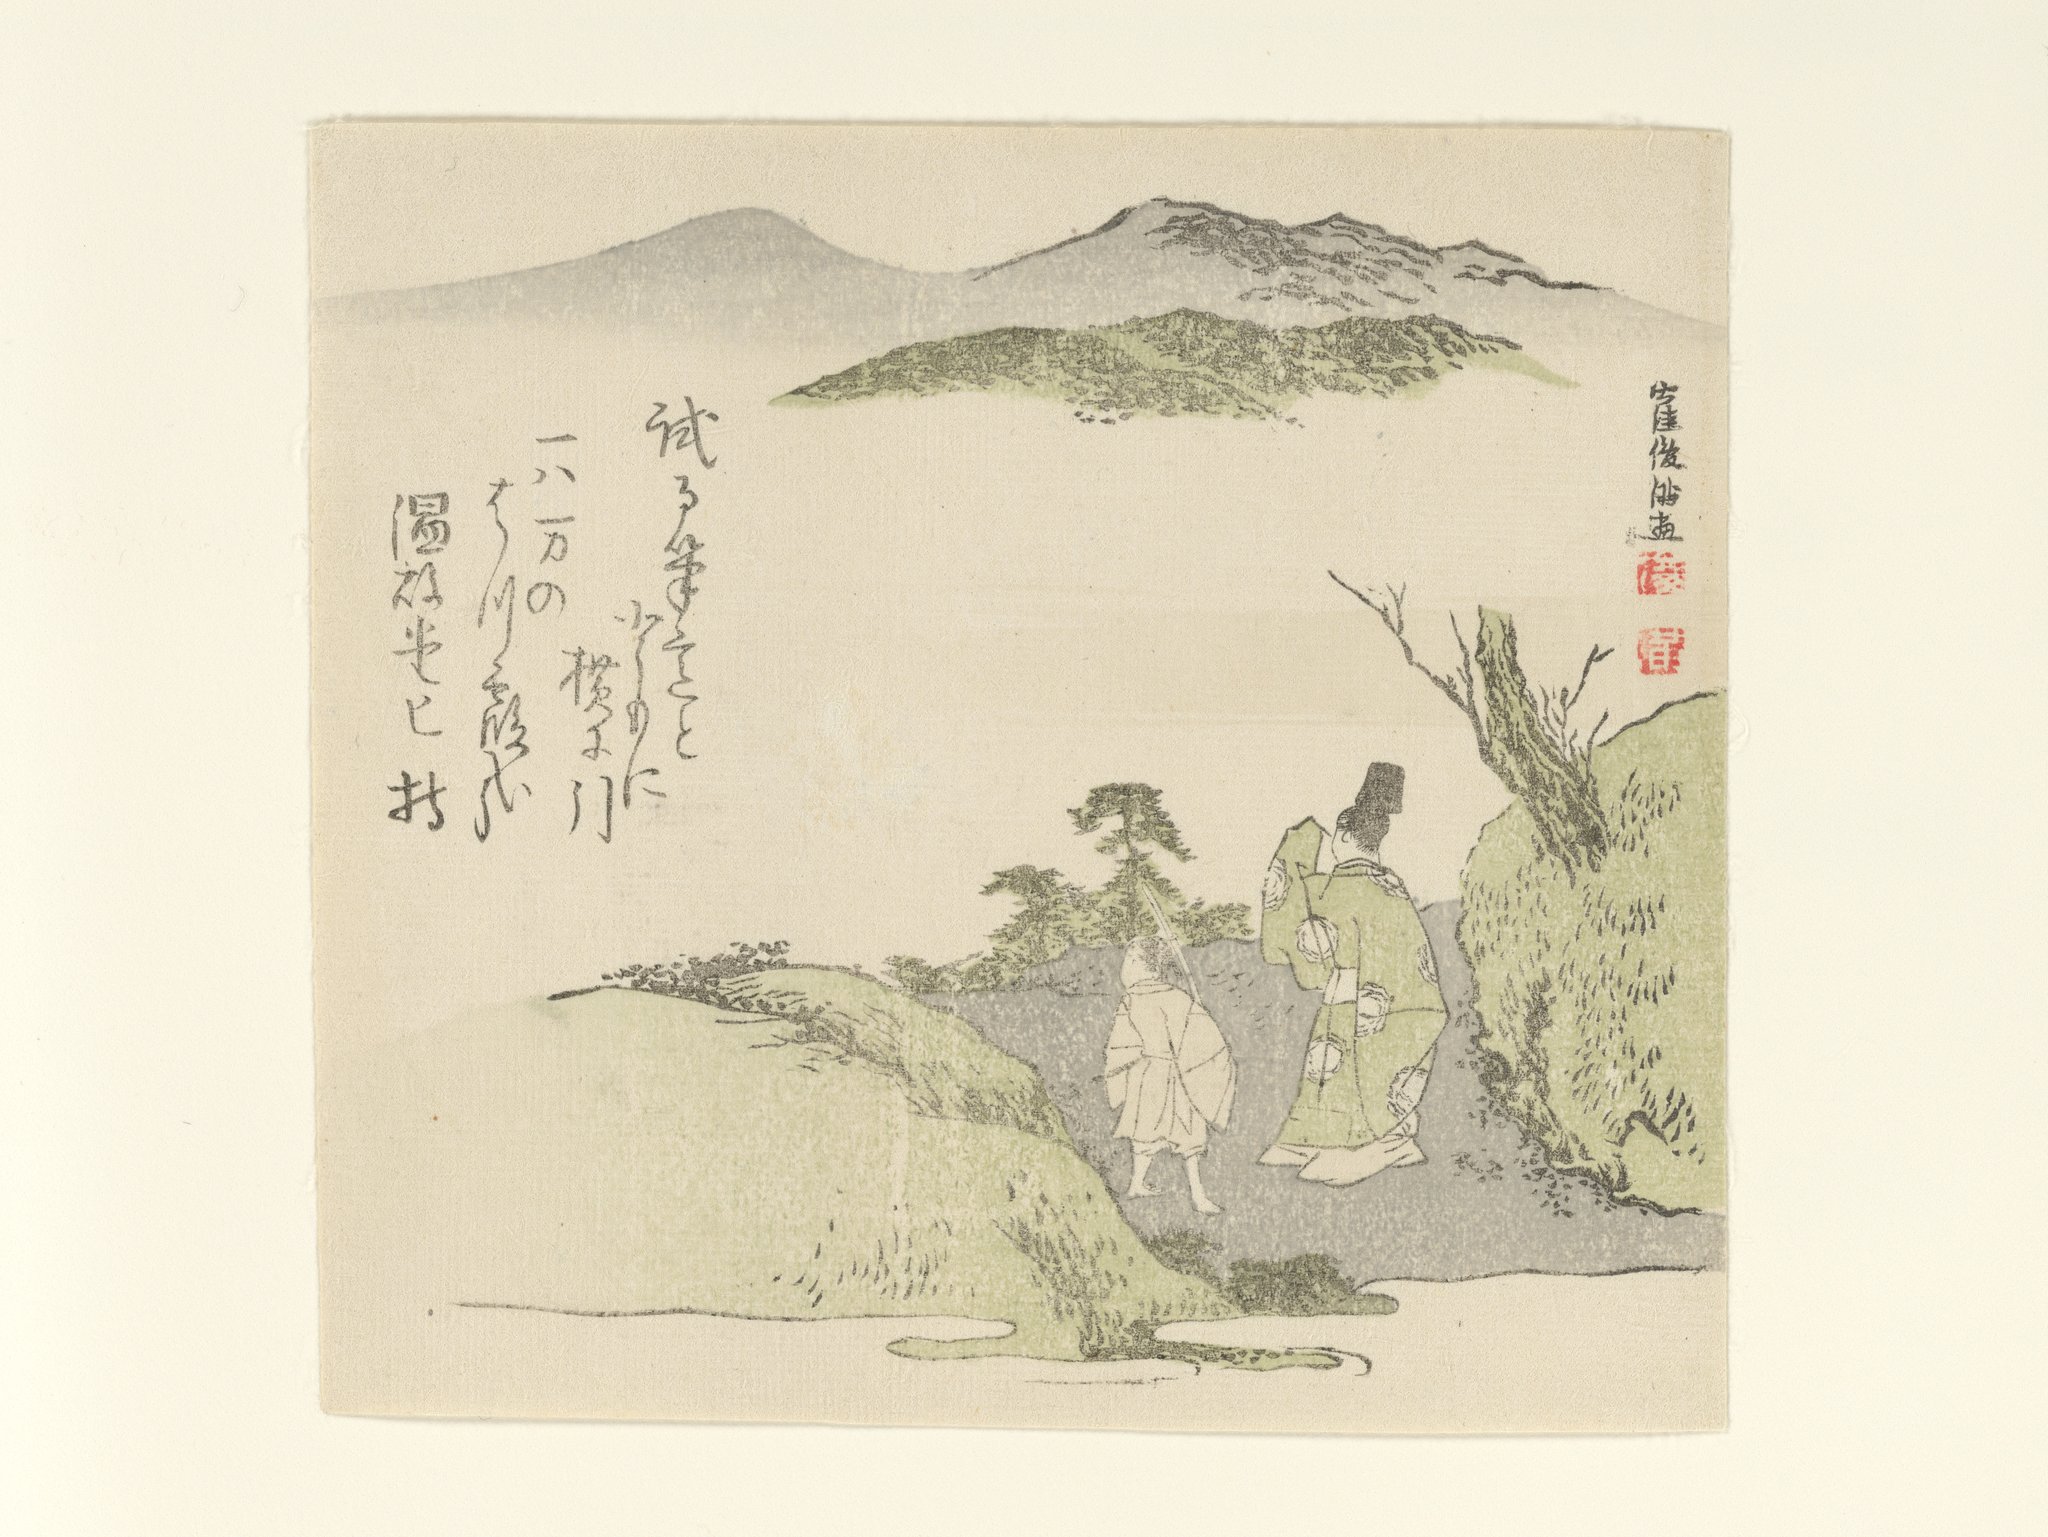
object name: print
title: Courtier and Young Attendant Gazing at a Landscape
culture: japanese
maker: kubo shunman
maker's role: artist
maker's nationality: japanese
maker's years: 1757-1820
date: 1796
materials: ink, paper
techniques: surimono, woodblock print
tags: human figures,landscapes